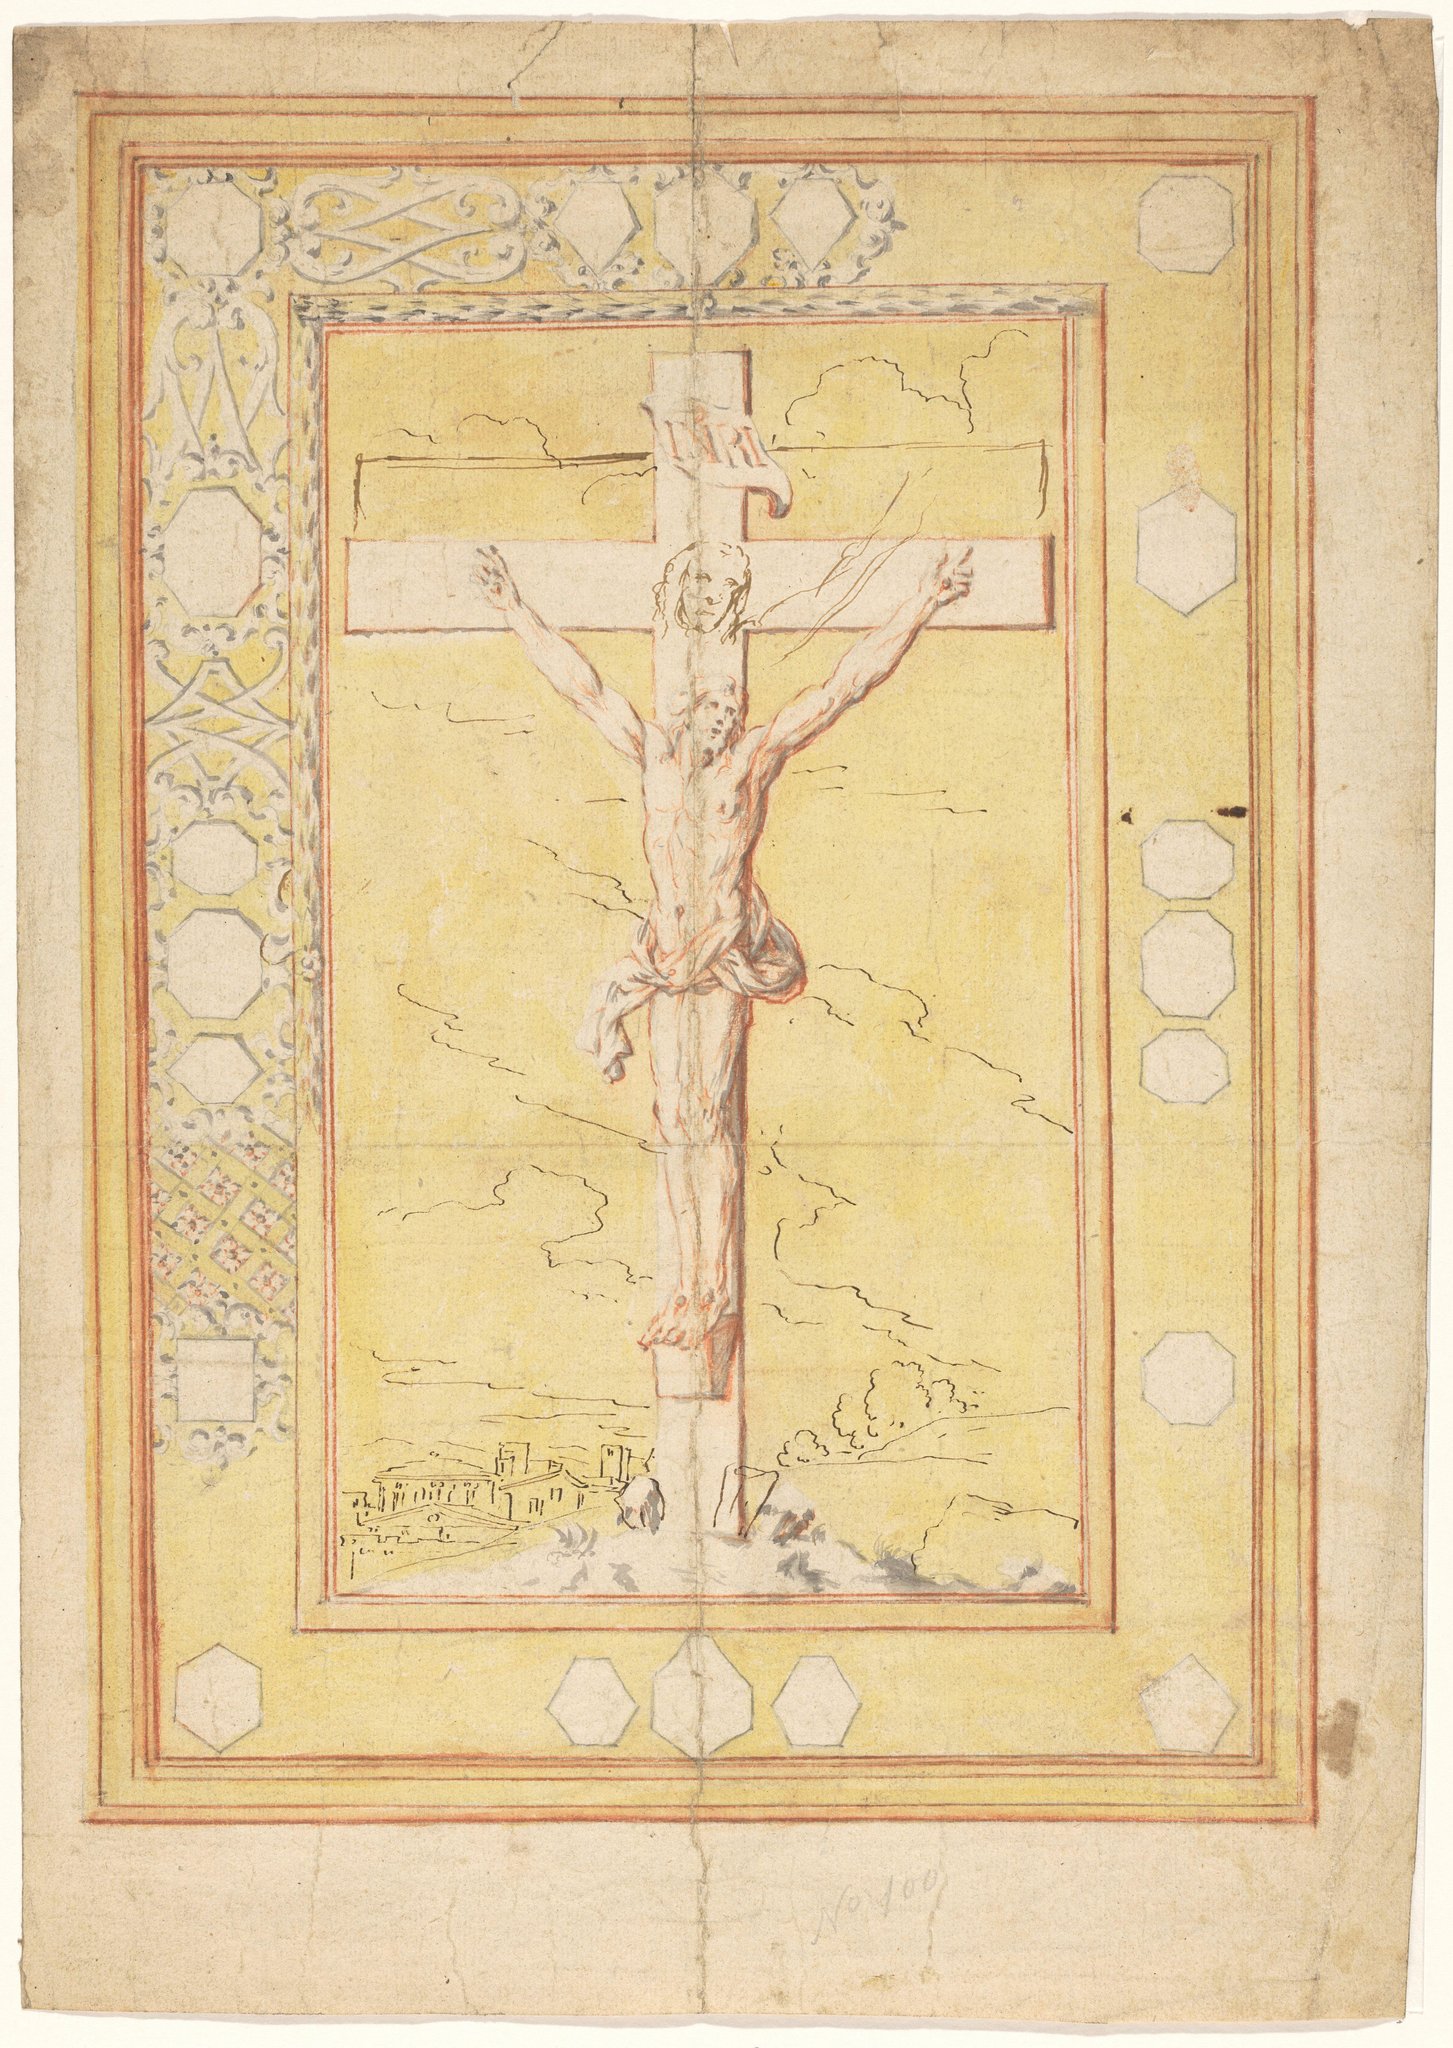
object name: design drawing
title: Ontwerp voor het beslag van een boekband, met de gekruisigde Christus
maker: Anonymous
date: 1700-1720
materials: graphite, paper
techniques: brush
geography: paris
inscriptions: number: ‘No. 100’, watermark